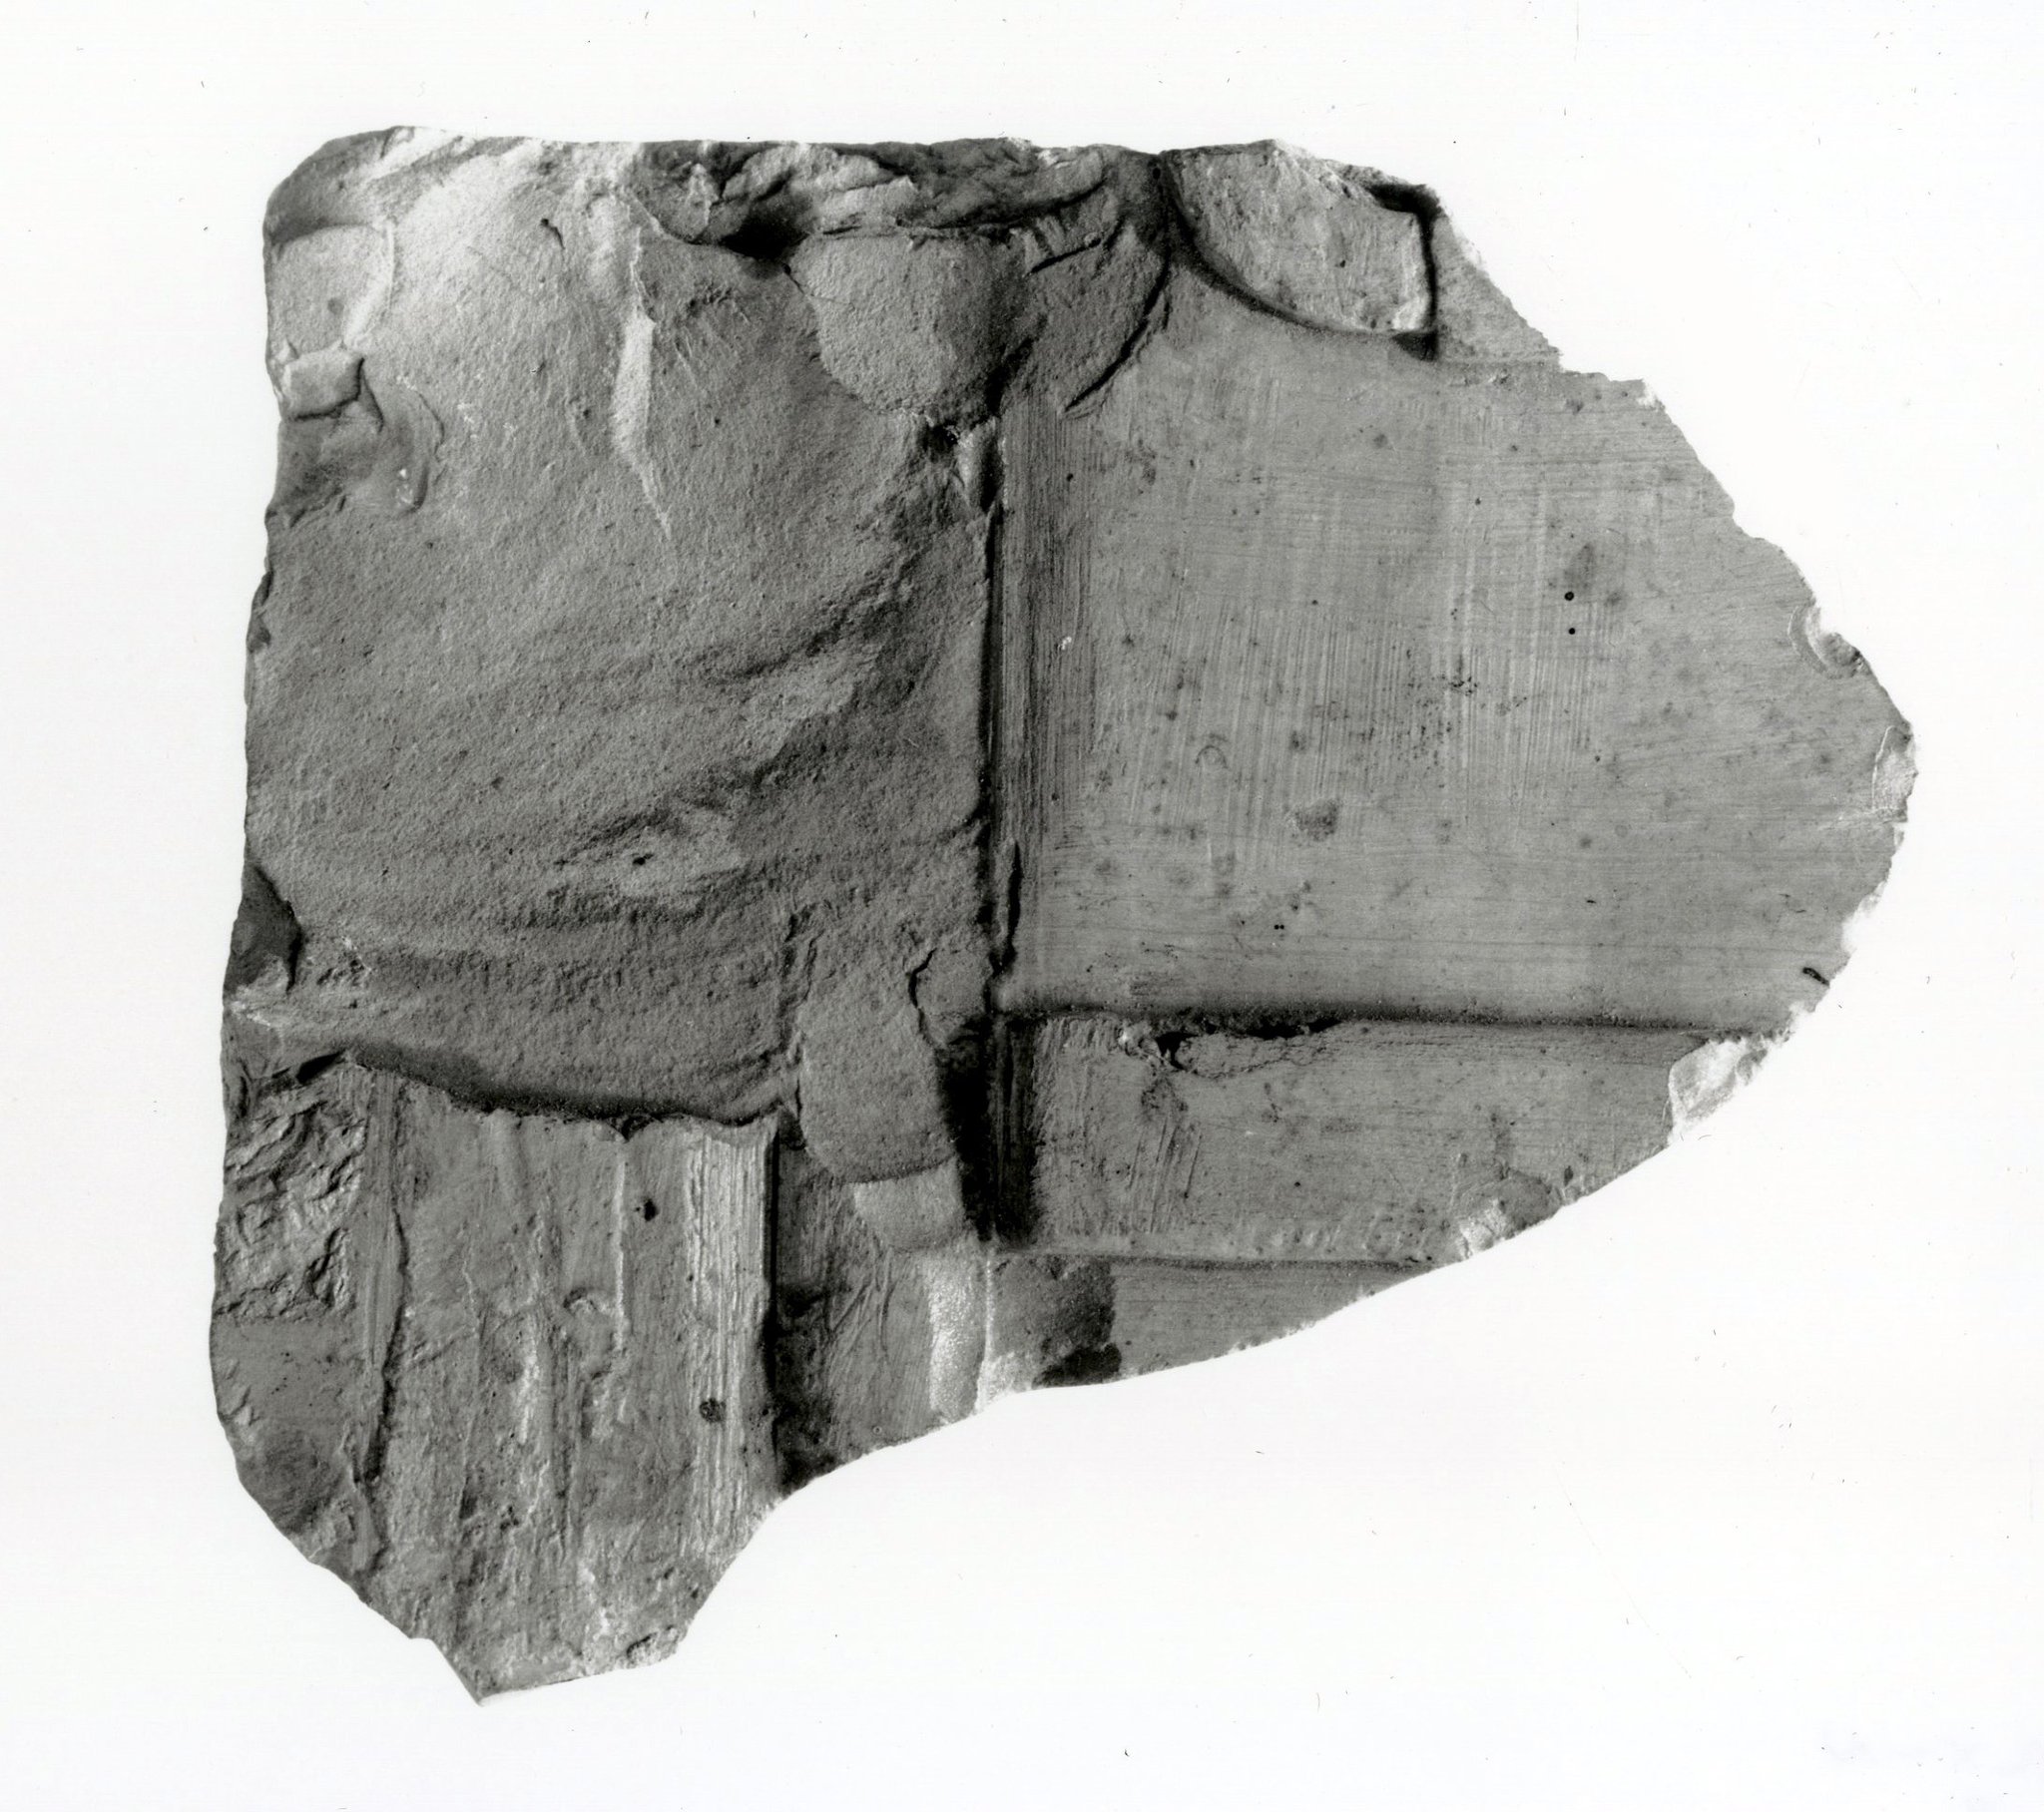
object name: relief, tomb of nespekashuty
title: Raised relief fragment with part of an inscription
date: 664-610 BCE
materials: limestone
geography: egypt